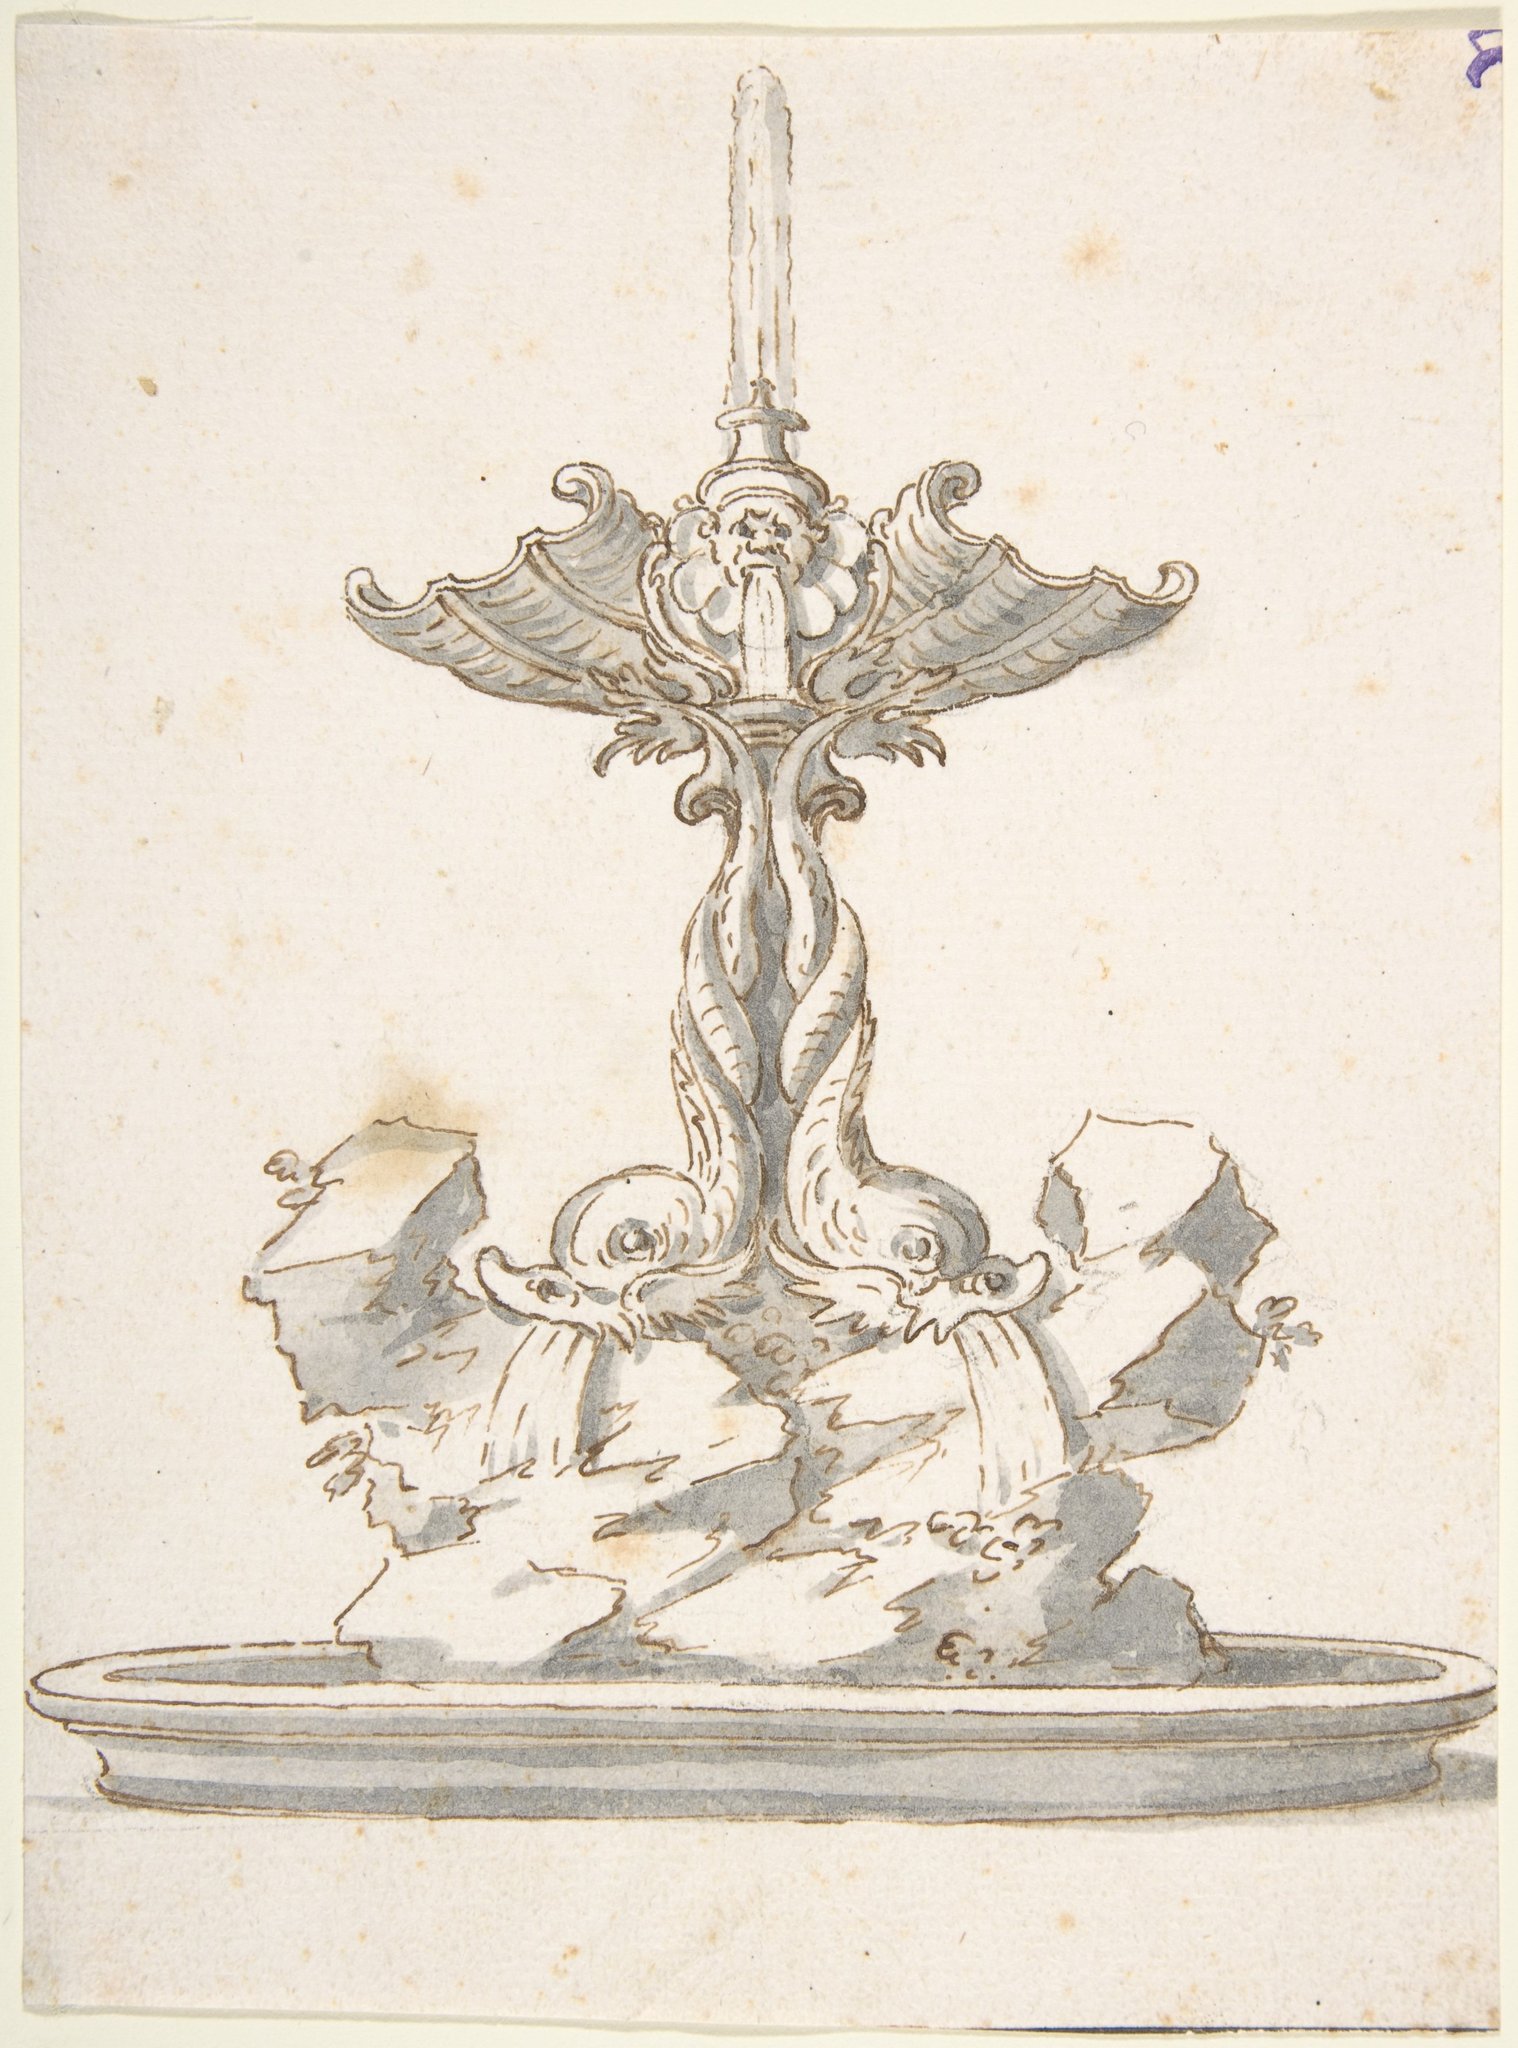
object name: drawing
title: Design for Fountain with Dolphins and Grotesque Head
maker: anonymous, italian, 18th century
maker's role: artist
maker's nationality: italian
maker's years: 1700-1800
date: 1701-1800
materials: ink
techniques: pen, wash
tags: fountains,dolphins